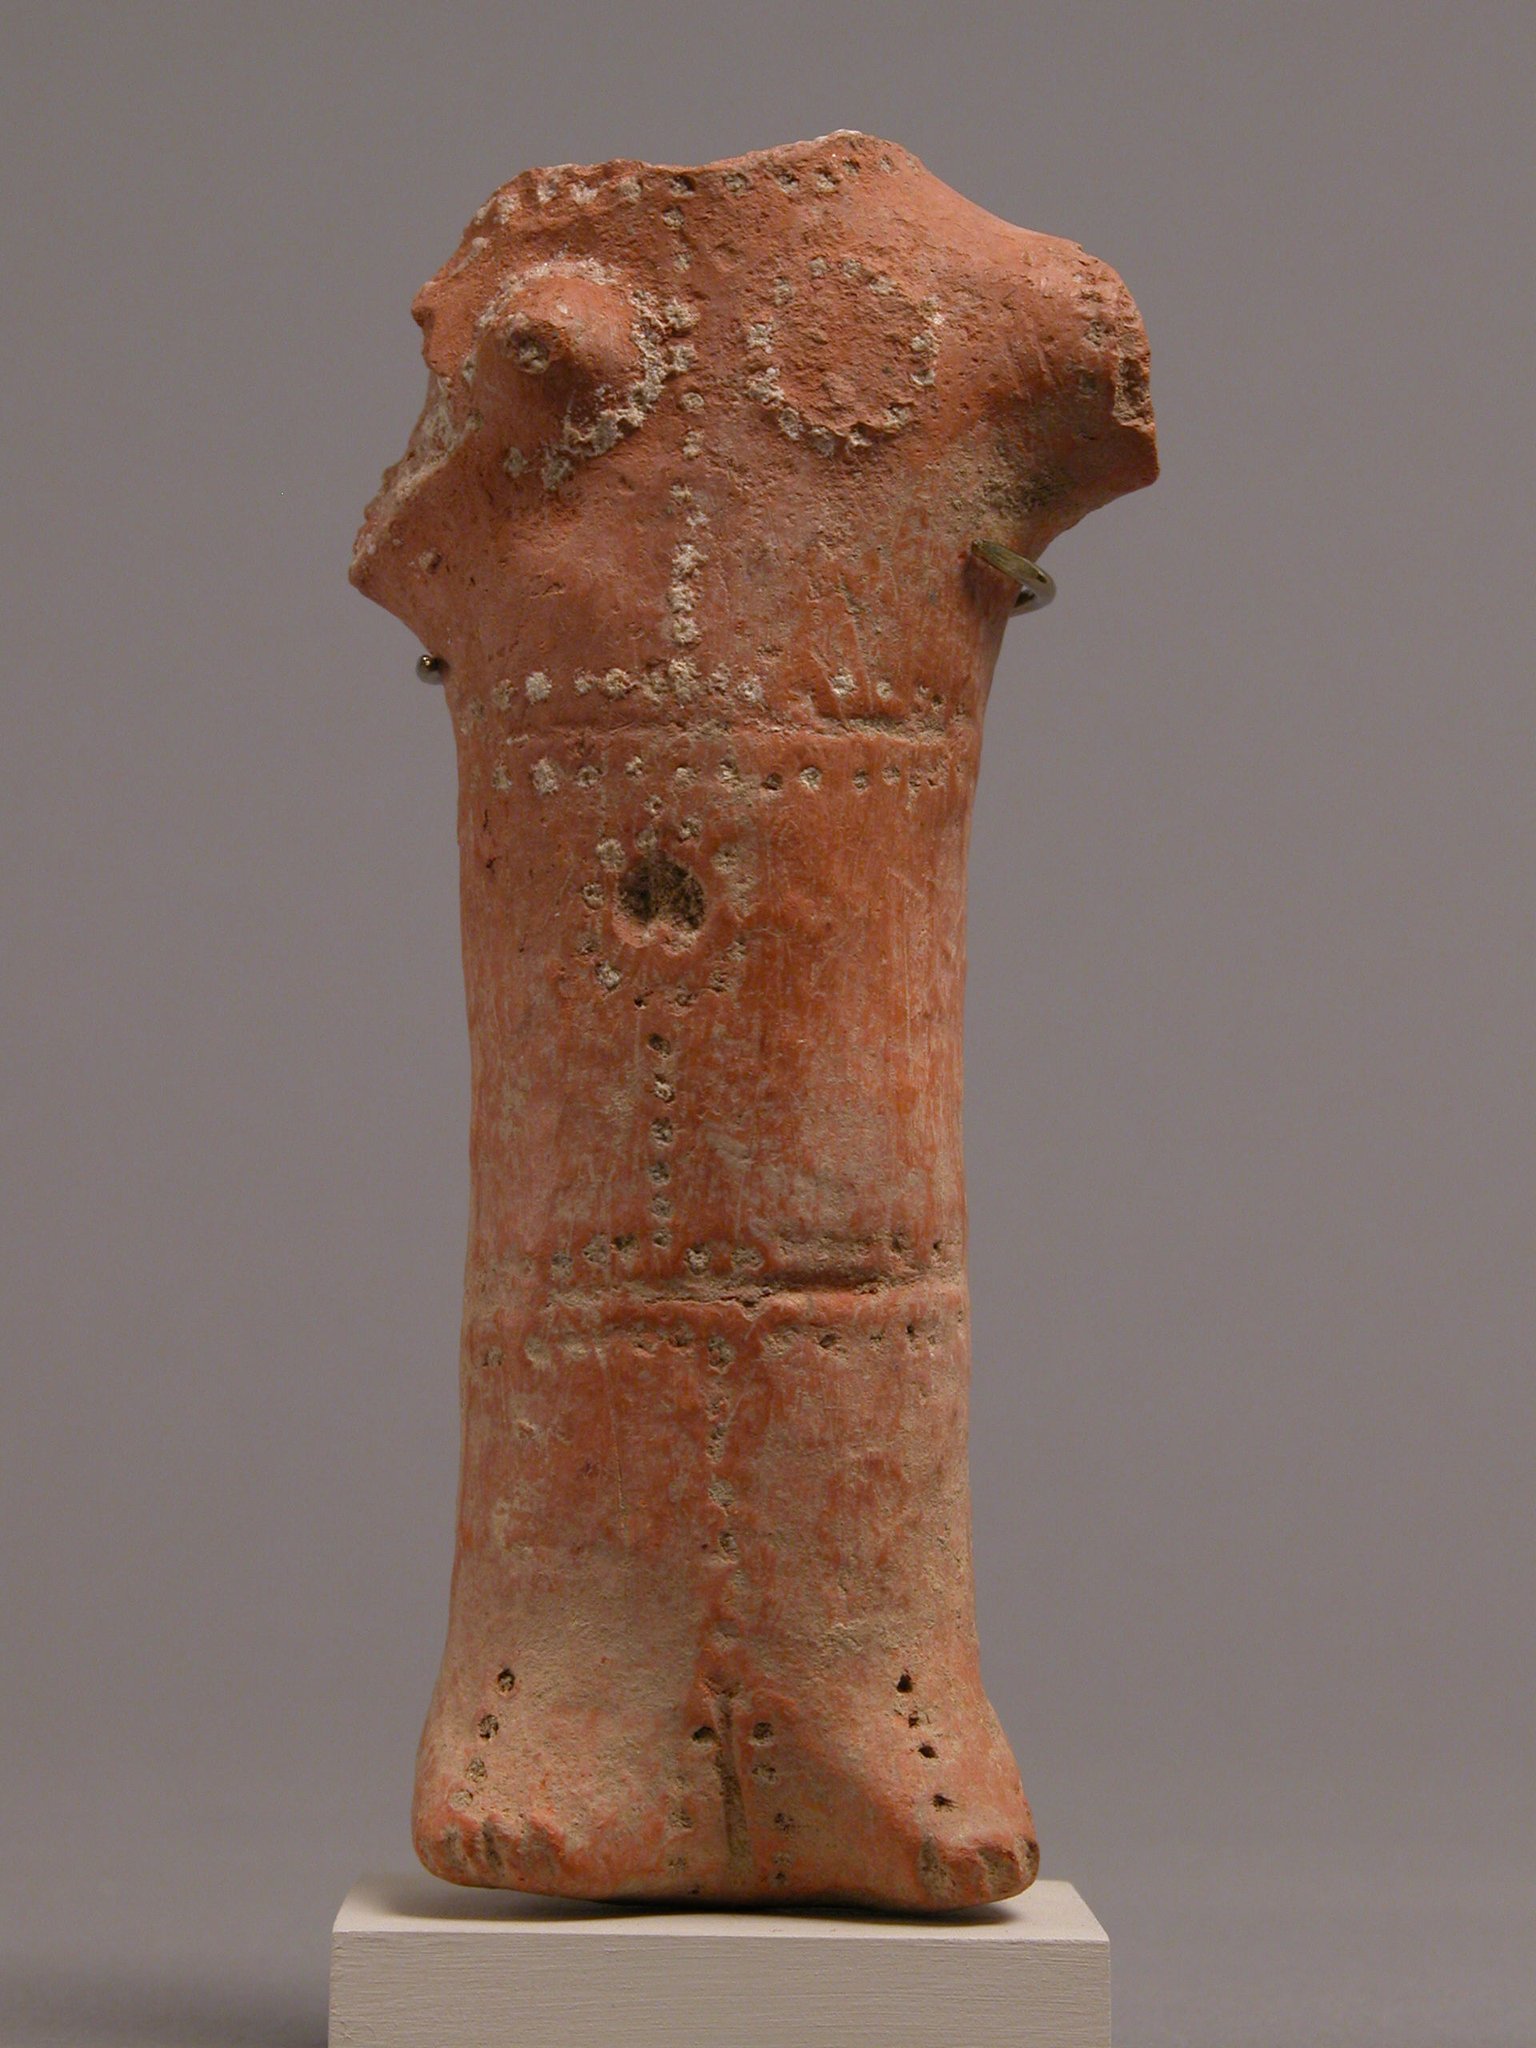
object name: statuette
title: Fragment of a Female Figure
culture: coptic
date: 301-700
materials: earthenware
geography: egypt